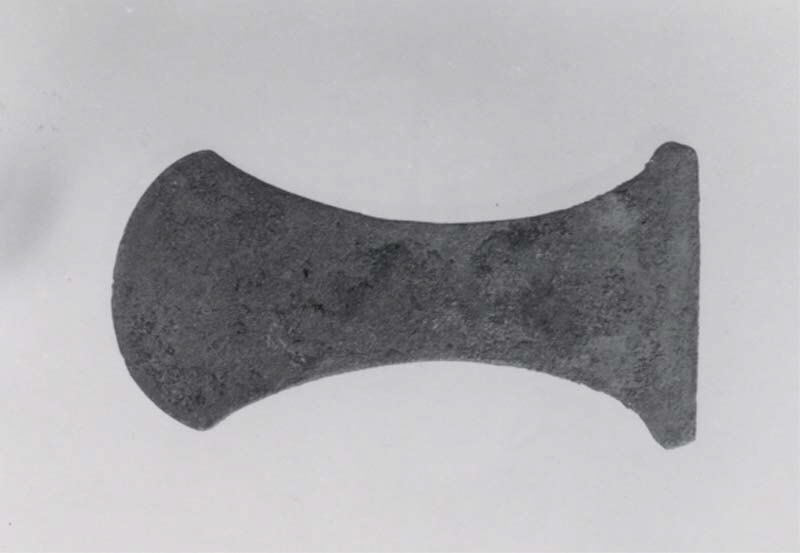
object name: axe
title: Axe head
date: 2000-1001 BCE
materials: bronze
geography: levant